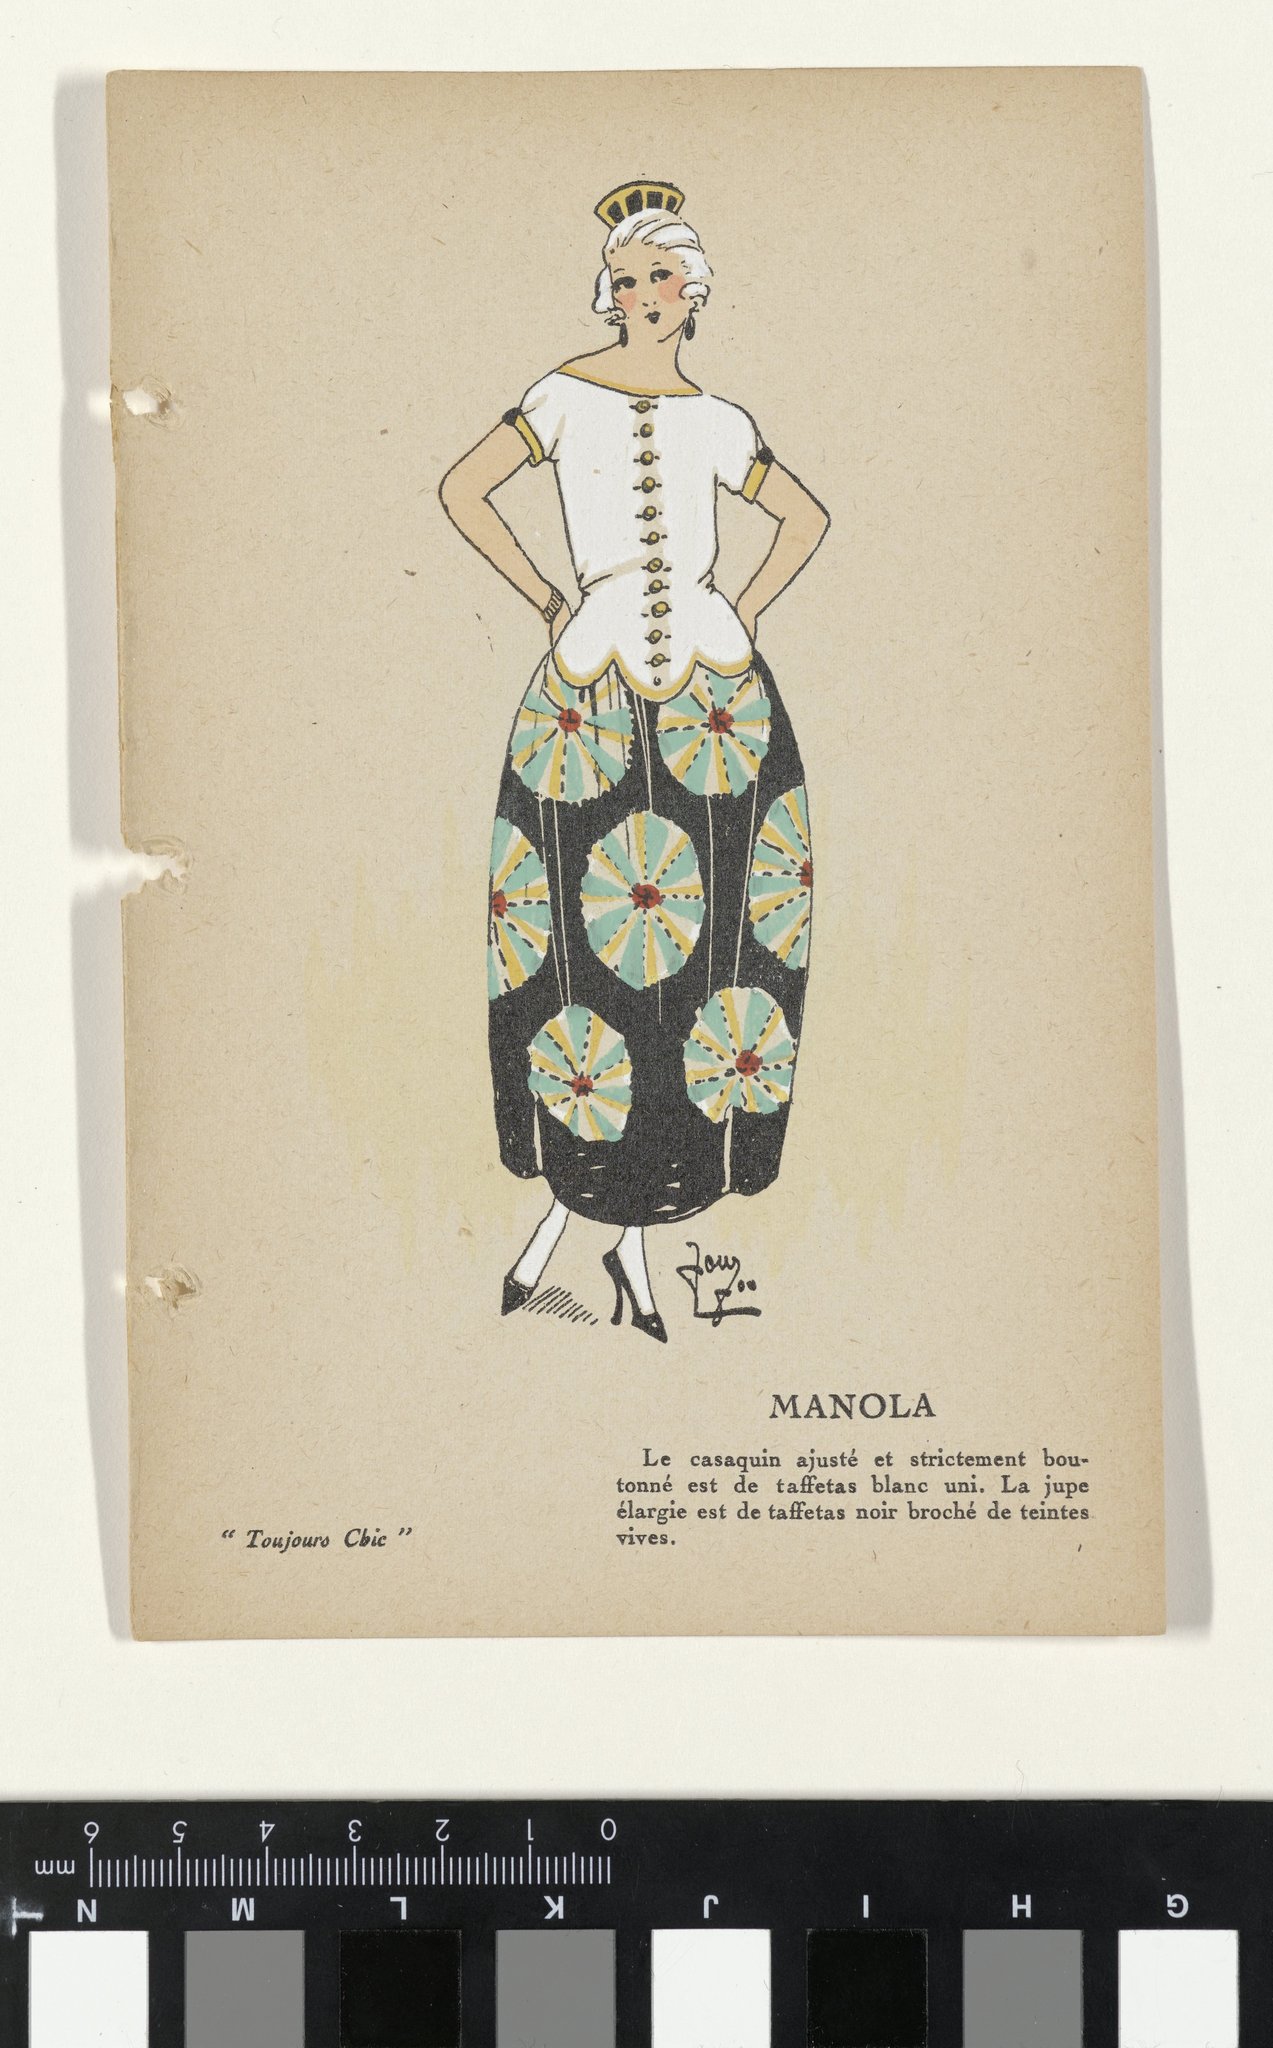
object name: fashion print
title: Toujours Chic Les Robes, Hiver 1921-1922: Manola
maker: g-p. joumard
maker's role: publisher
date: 1921-1922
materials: paper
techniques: letterpress printing, pochoir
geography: paris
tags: fashion plates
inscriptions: date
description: Prent uit Catalogus "Toujours Chic" waarin een overzicht van de wintermode 1921-1922 in 80 prentjes in pochoir techniek.